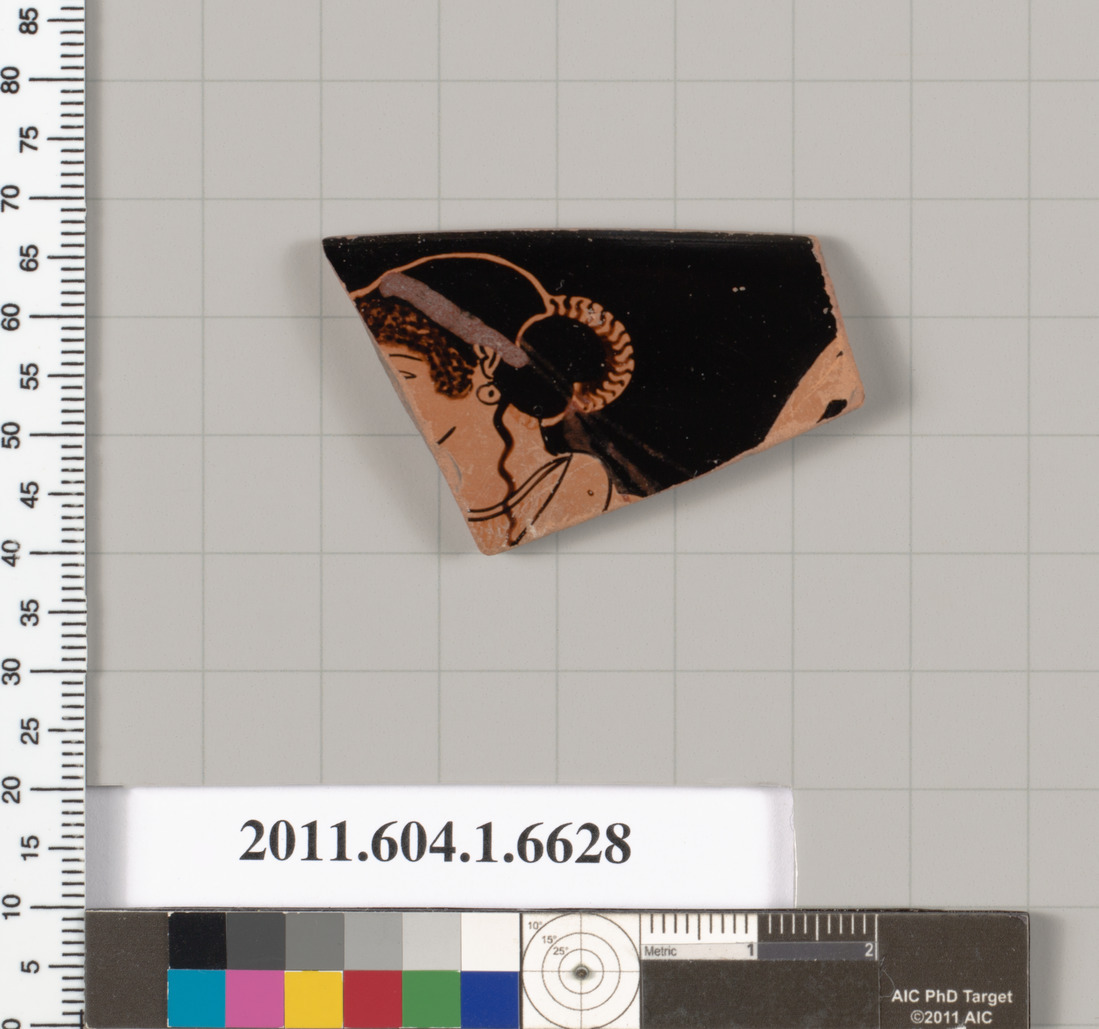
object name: kylix fragment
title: Terracotta rim fragment of a kylix (drinking cup)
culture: greek, attic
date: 490-470 BCE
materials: terracotta